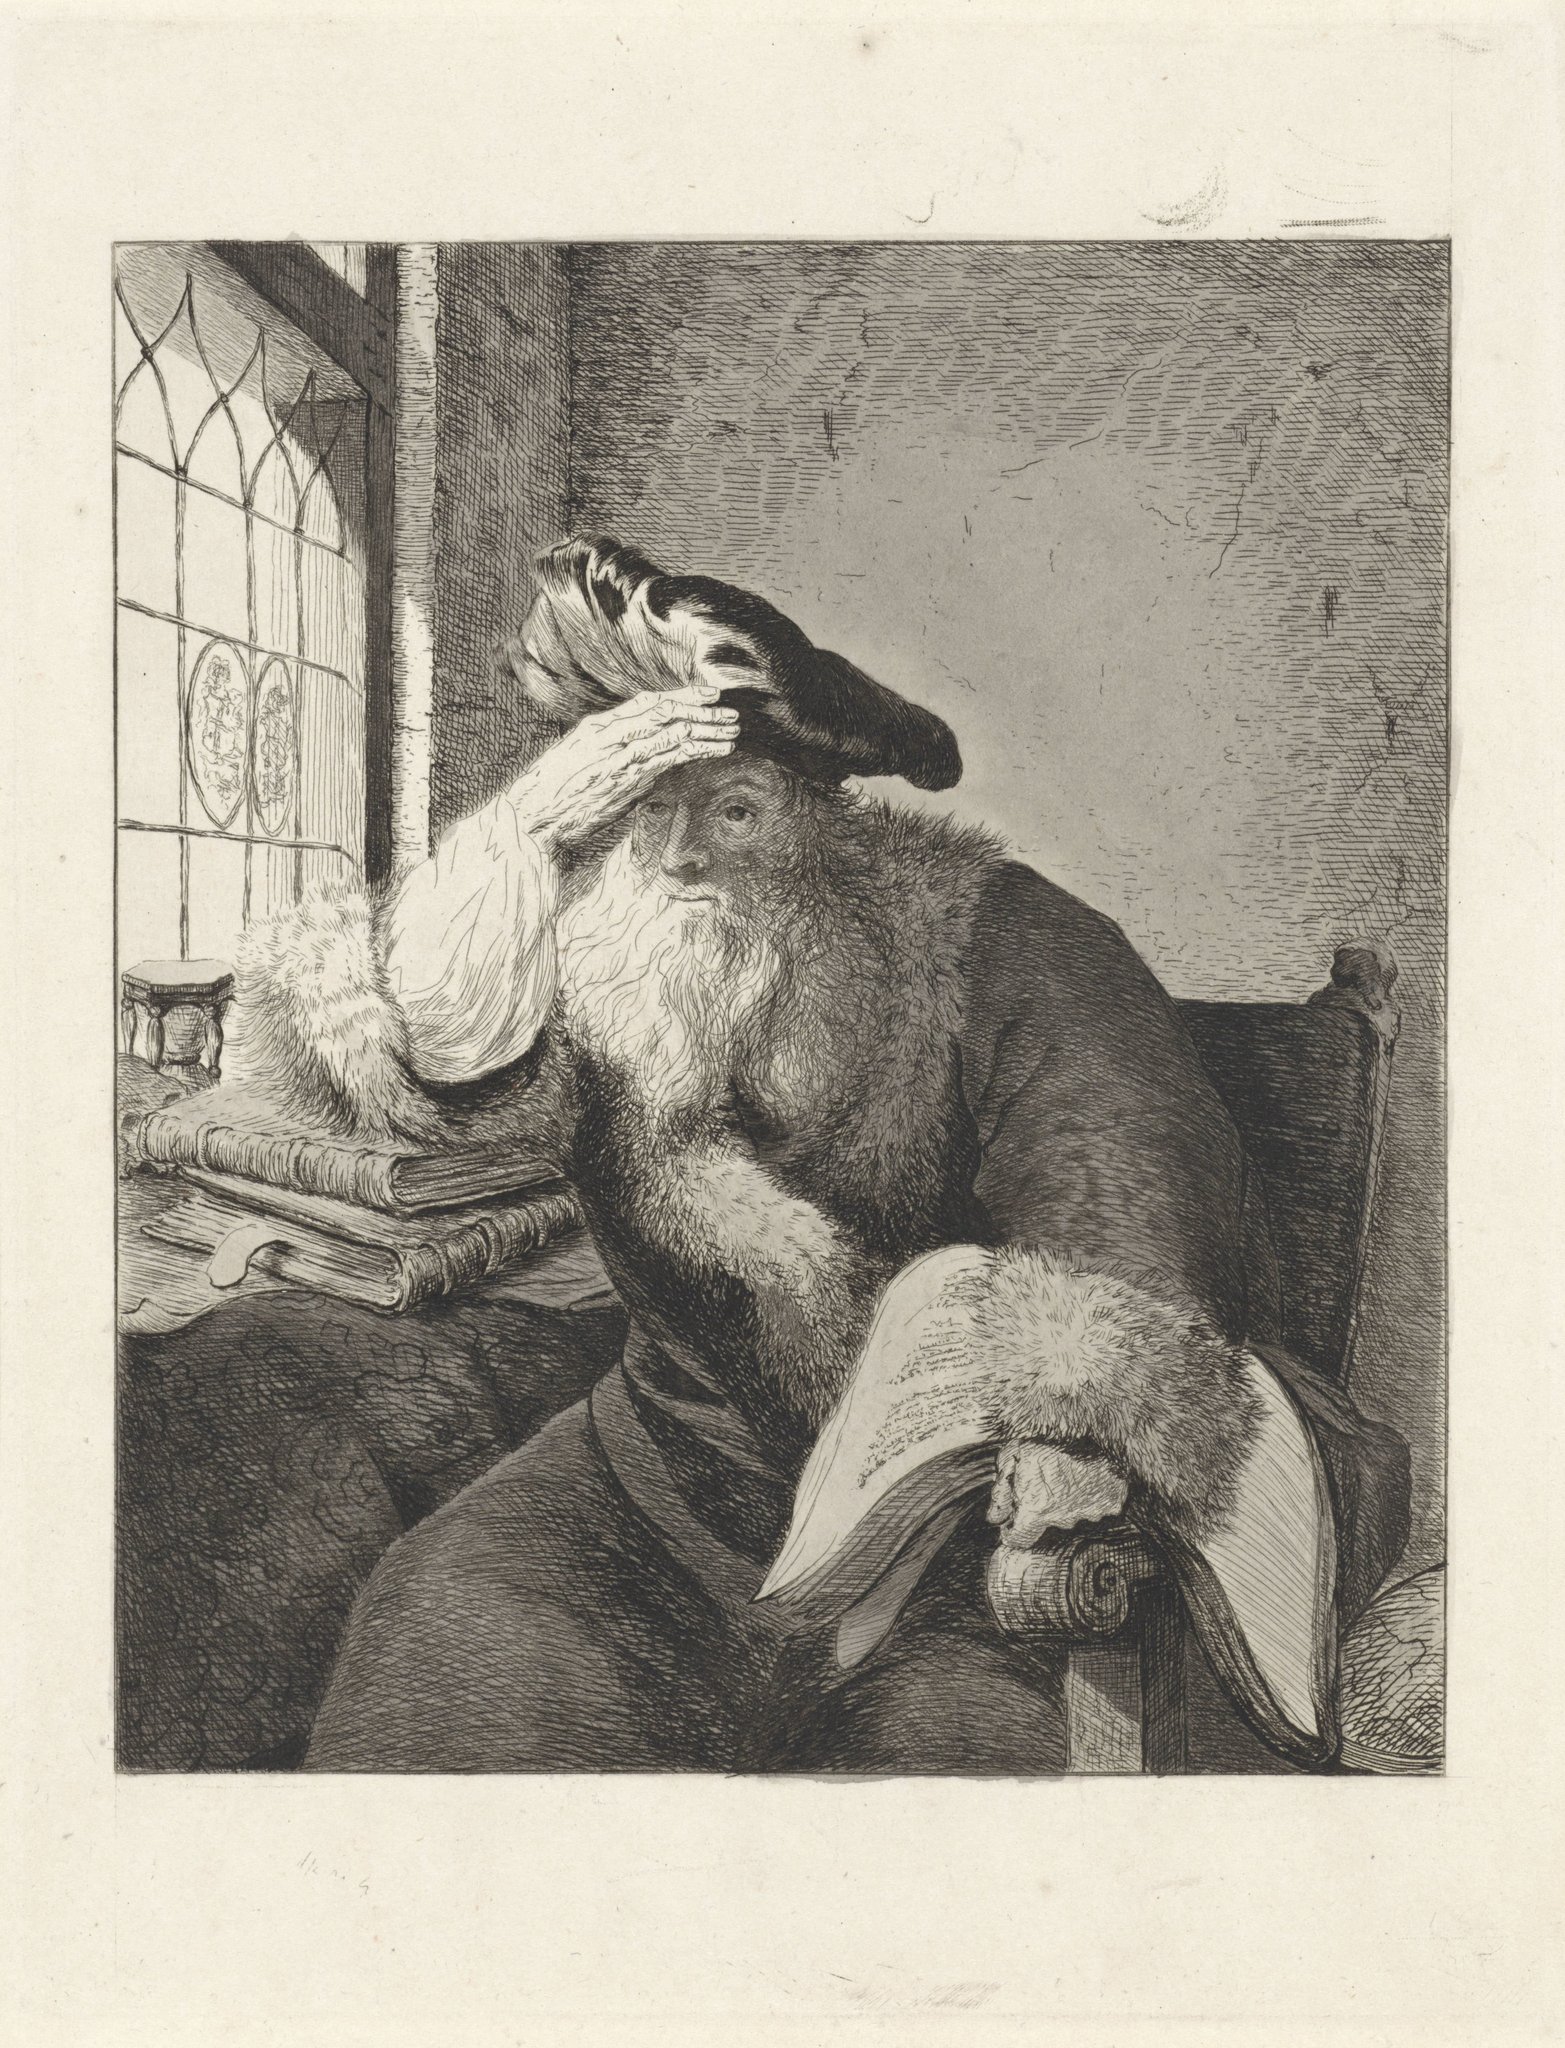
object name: print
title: Grijsaard aan het venster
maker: diederik jan singendonck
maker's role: print maker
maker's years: 1784-1833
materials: paper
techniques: brush, engraving, etching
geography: utrecht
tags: book, skull as symbol of 'vanitas', hourglass, globe, historical persons not known by name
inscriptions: collector's mark: Lugt 2228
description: Een oude man met een grote baret en met bont afgezette mantel zit op een stoel voor een raam. Zijn arm rust op een stapel boeken op een tafel. Met zijn andere hand houdt hij een boek vast dat op de armleuning van de stoel ligt. Naast de stoel staat een globe, op de tafel een zandloper en een schedel.